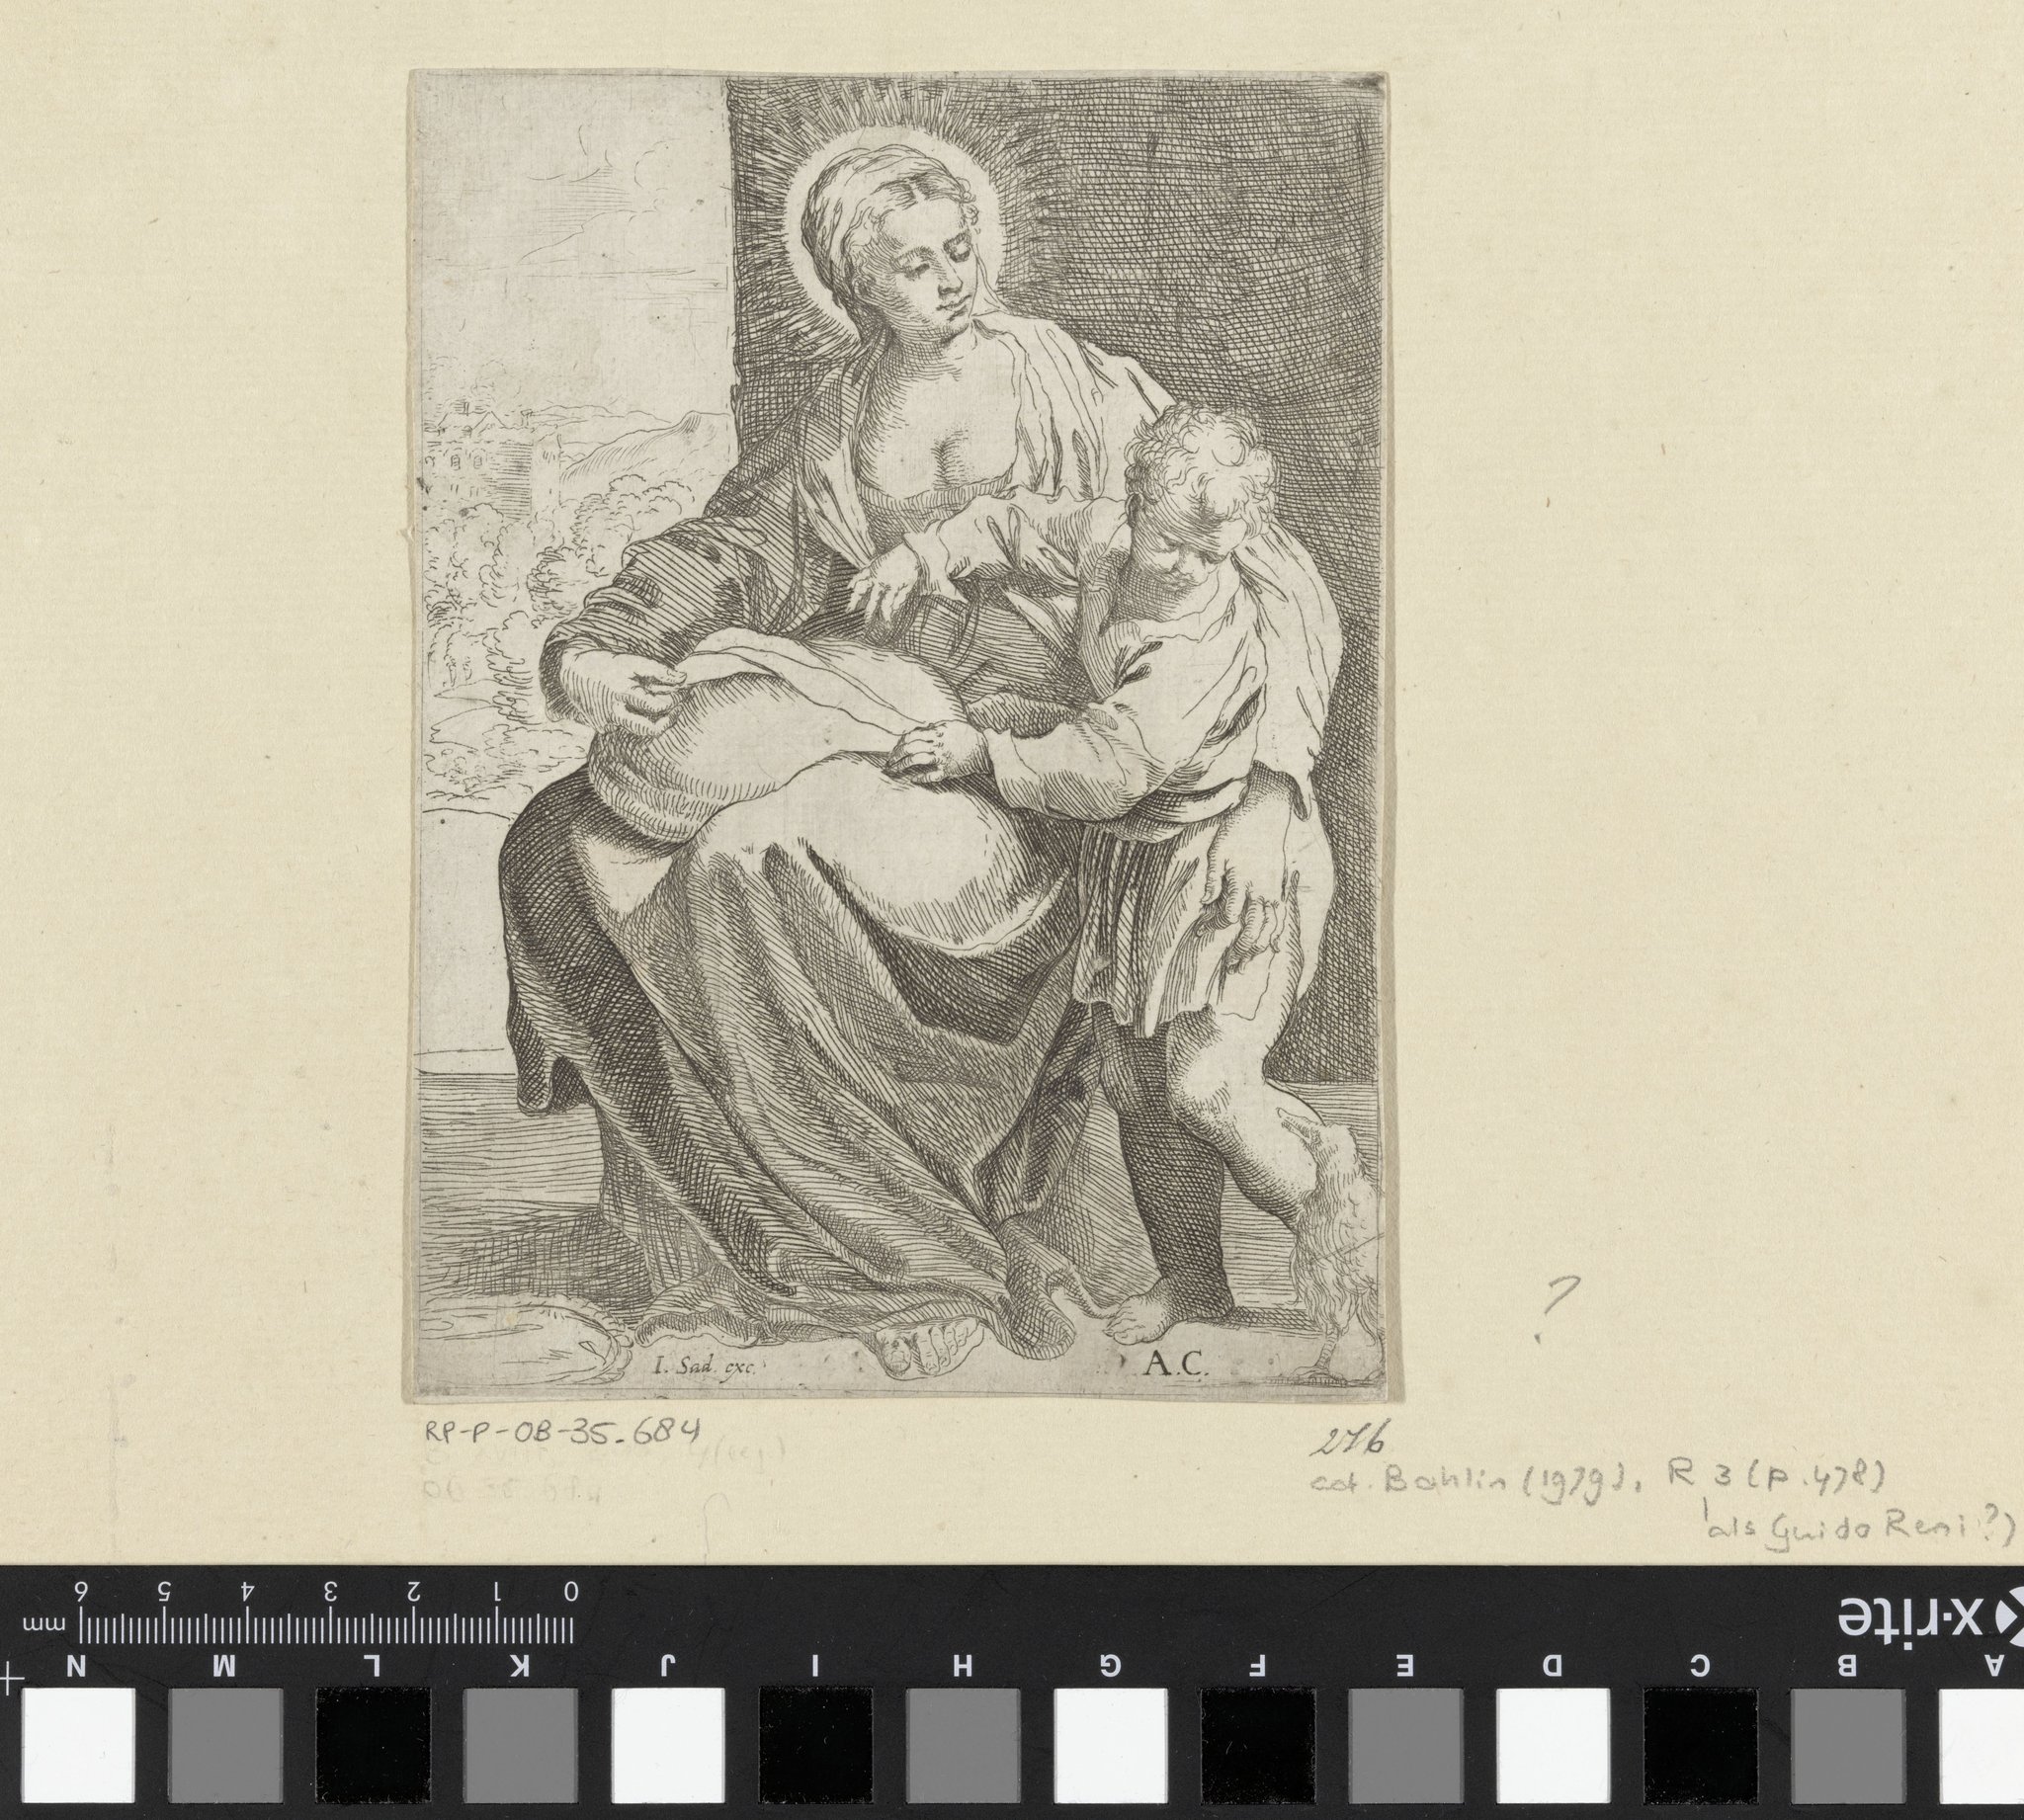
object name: print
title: Maria met kussen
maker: annibale carracci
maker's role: draughtsman, print maker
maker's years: 1560-1609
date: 1585-1642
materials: paper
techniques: etching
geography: italy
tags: madonna: i.e. mary with the christ-child, song-birds: crow, pillow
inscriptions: collector's mark: Lugt 240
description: Maria zit voor een muur met een kussen op haar schoot. Naast haar staat de jonge Christus. Christus kijkt omlaag naar een kraai.